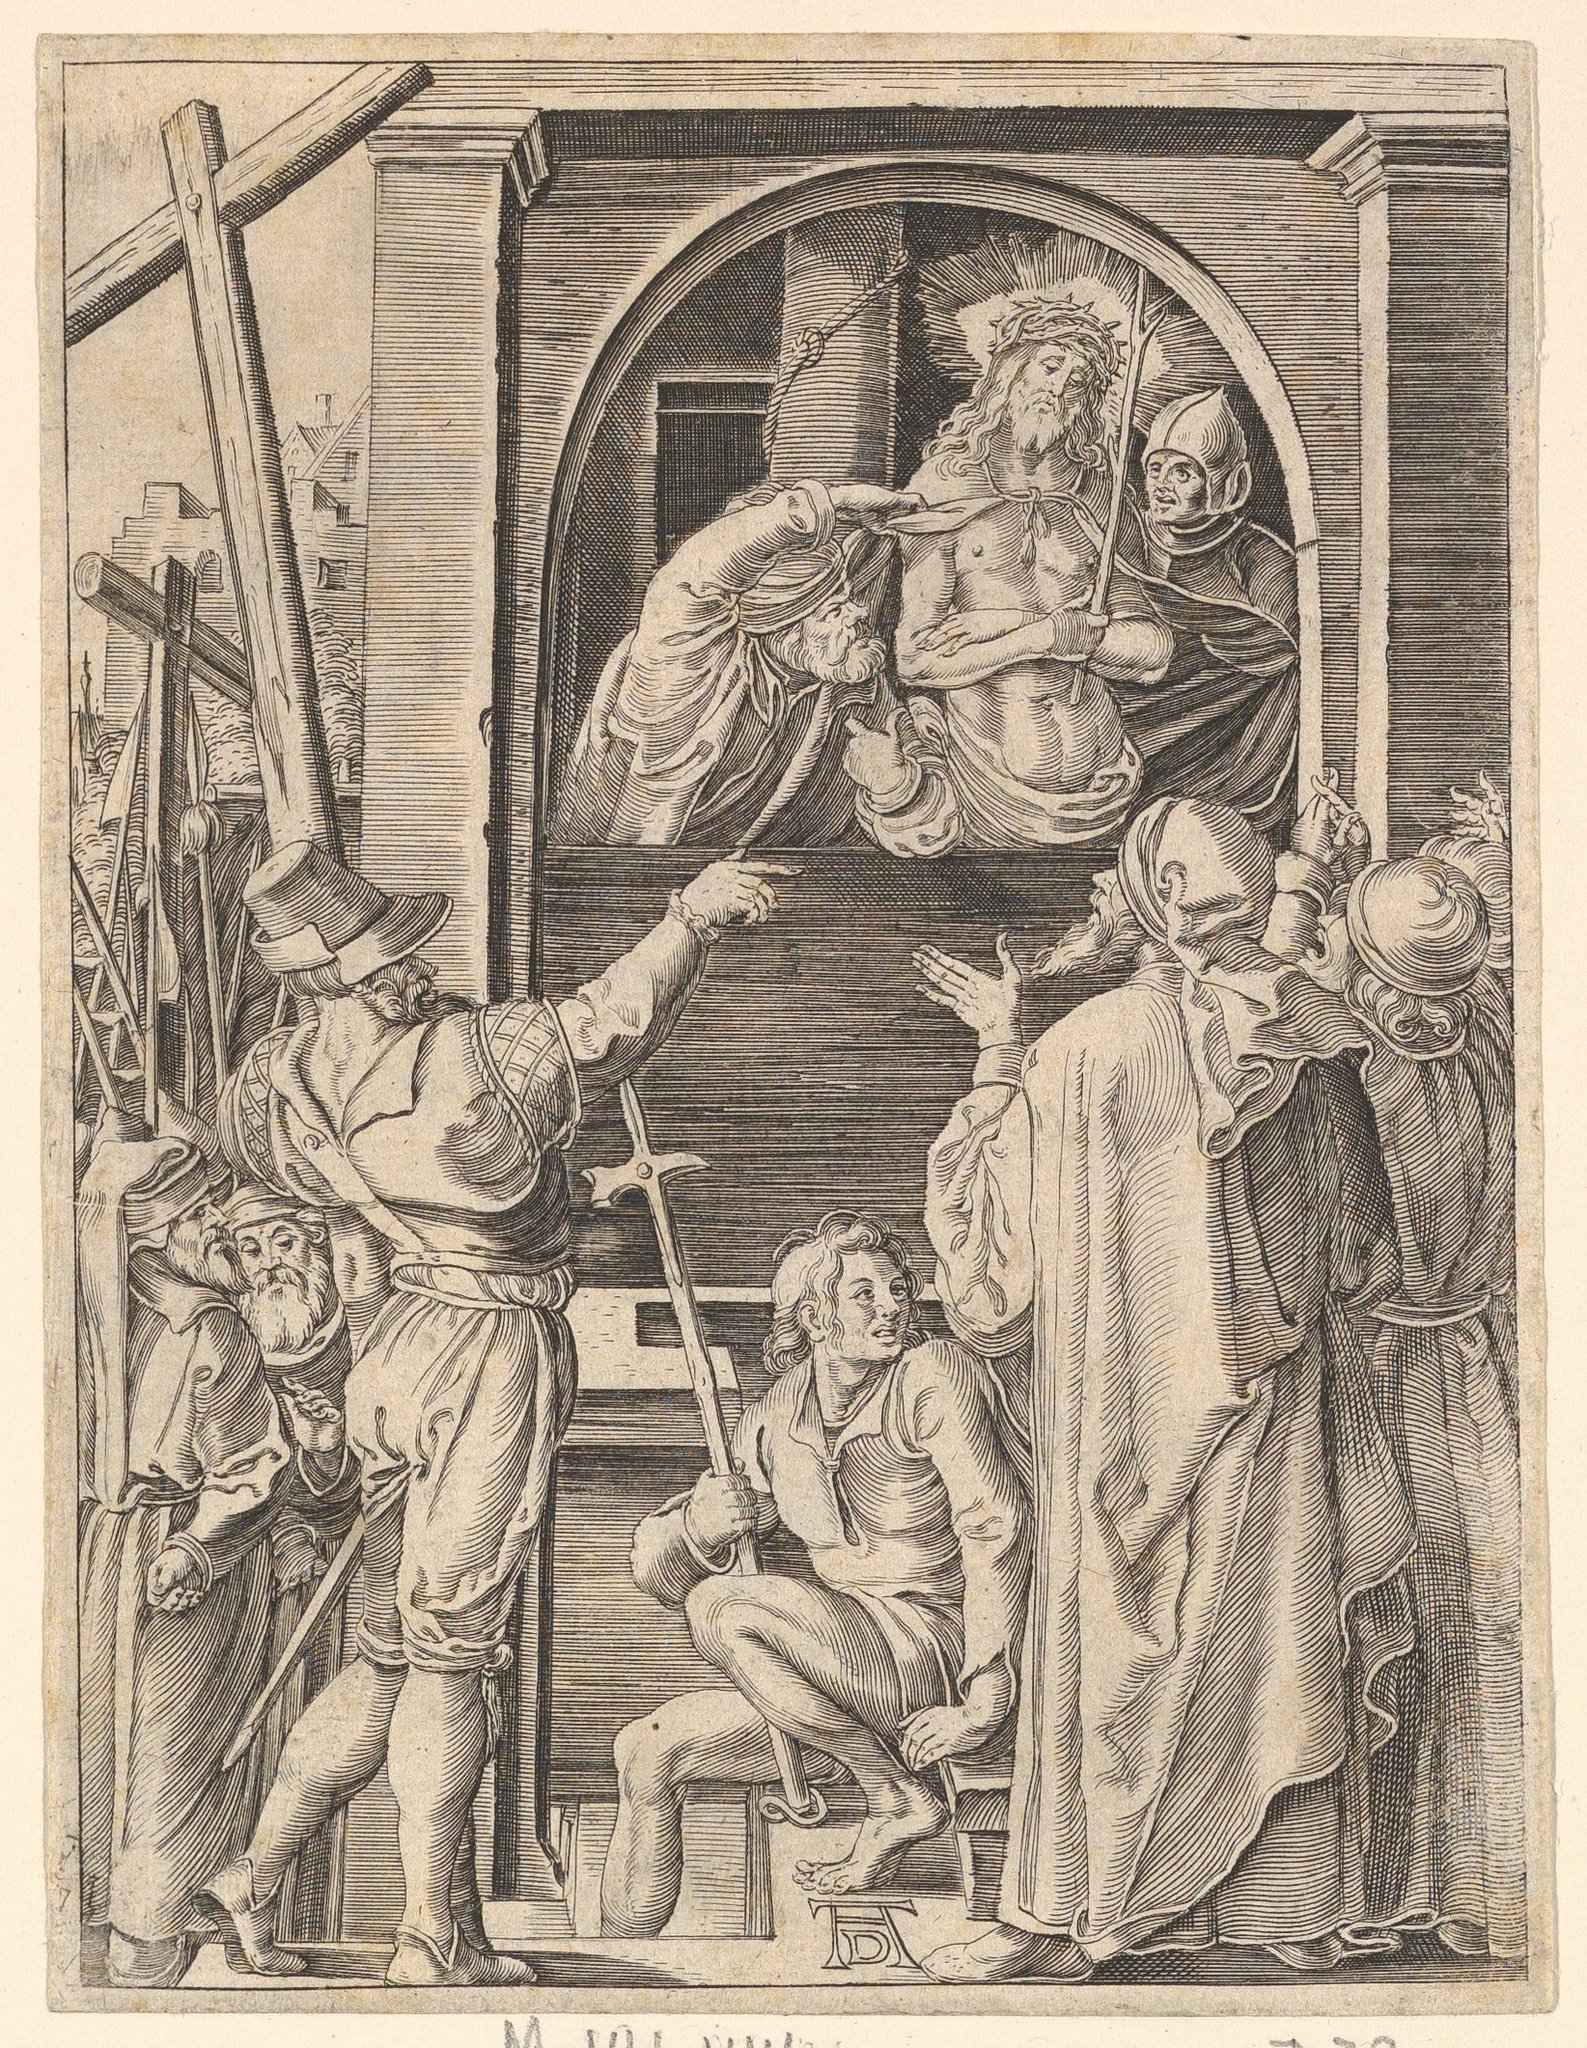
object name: print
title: Engraved copies of The Little Passion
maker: albrecht dürer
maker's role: artist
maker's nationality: german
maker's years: 1471-1528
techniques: engraving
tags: men,cross,jesus